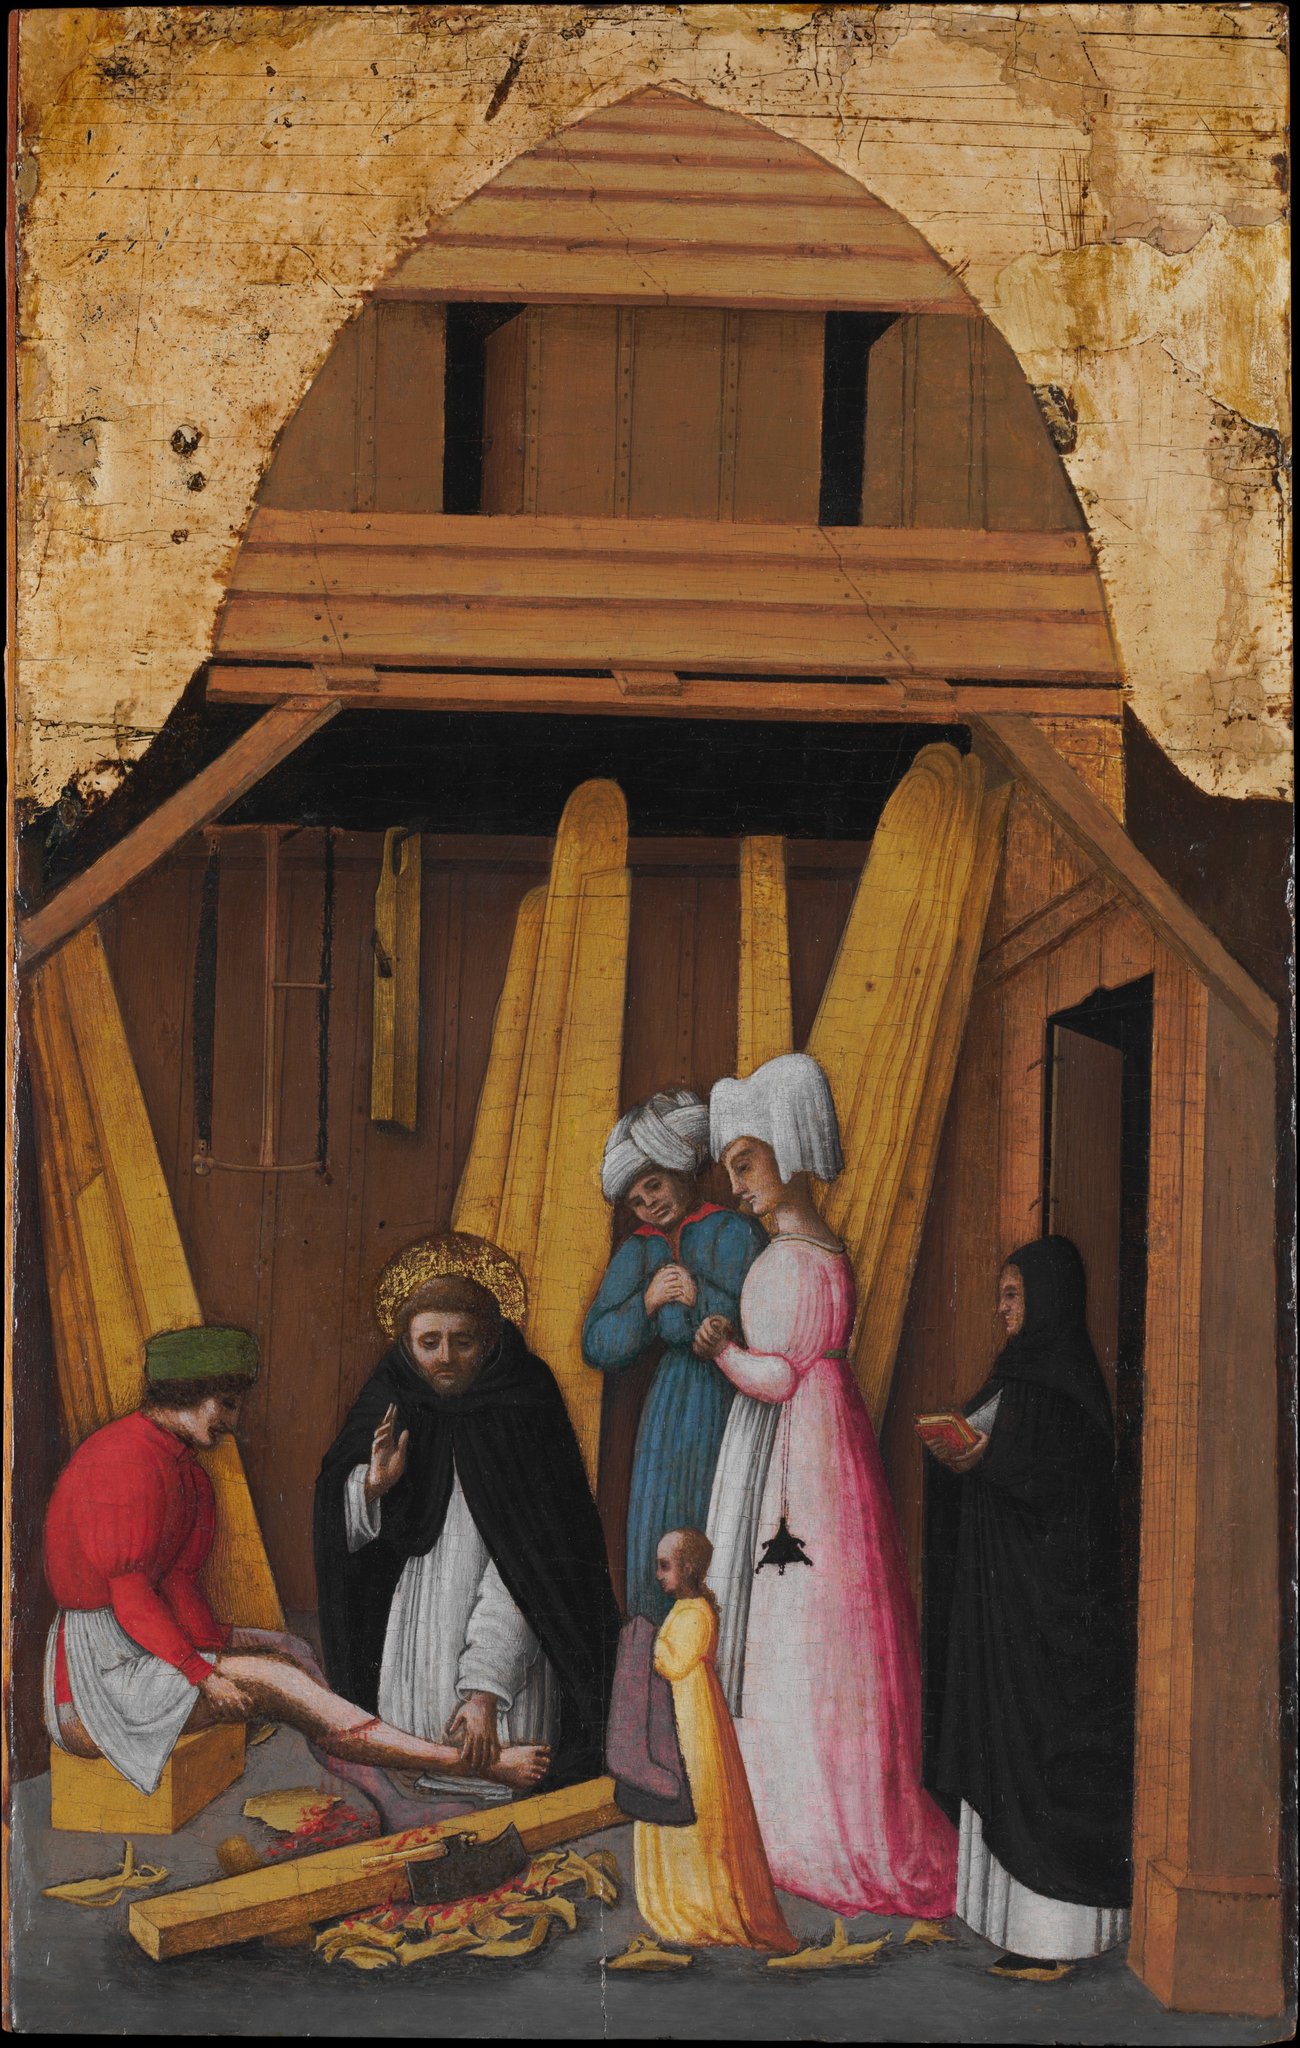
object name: painting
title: Saint Peter Martyr Healing the Leg of a Young Man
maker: antonio vivarini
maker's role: artist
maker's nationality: italian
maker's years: 1440-1484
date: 1450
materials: gold, paint, wood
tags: men,women,saint peter